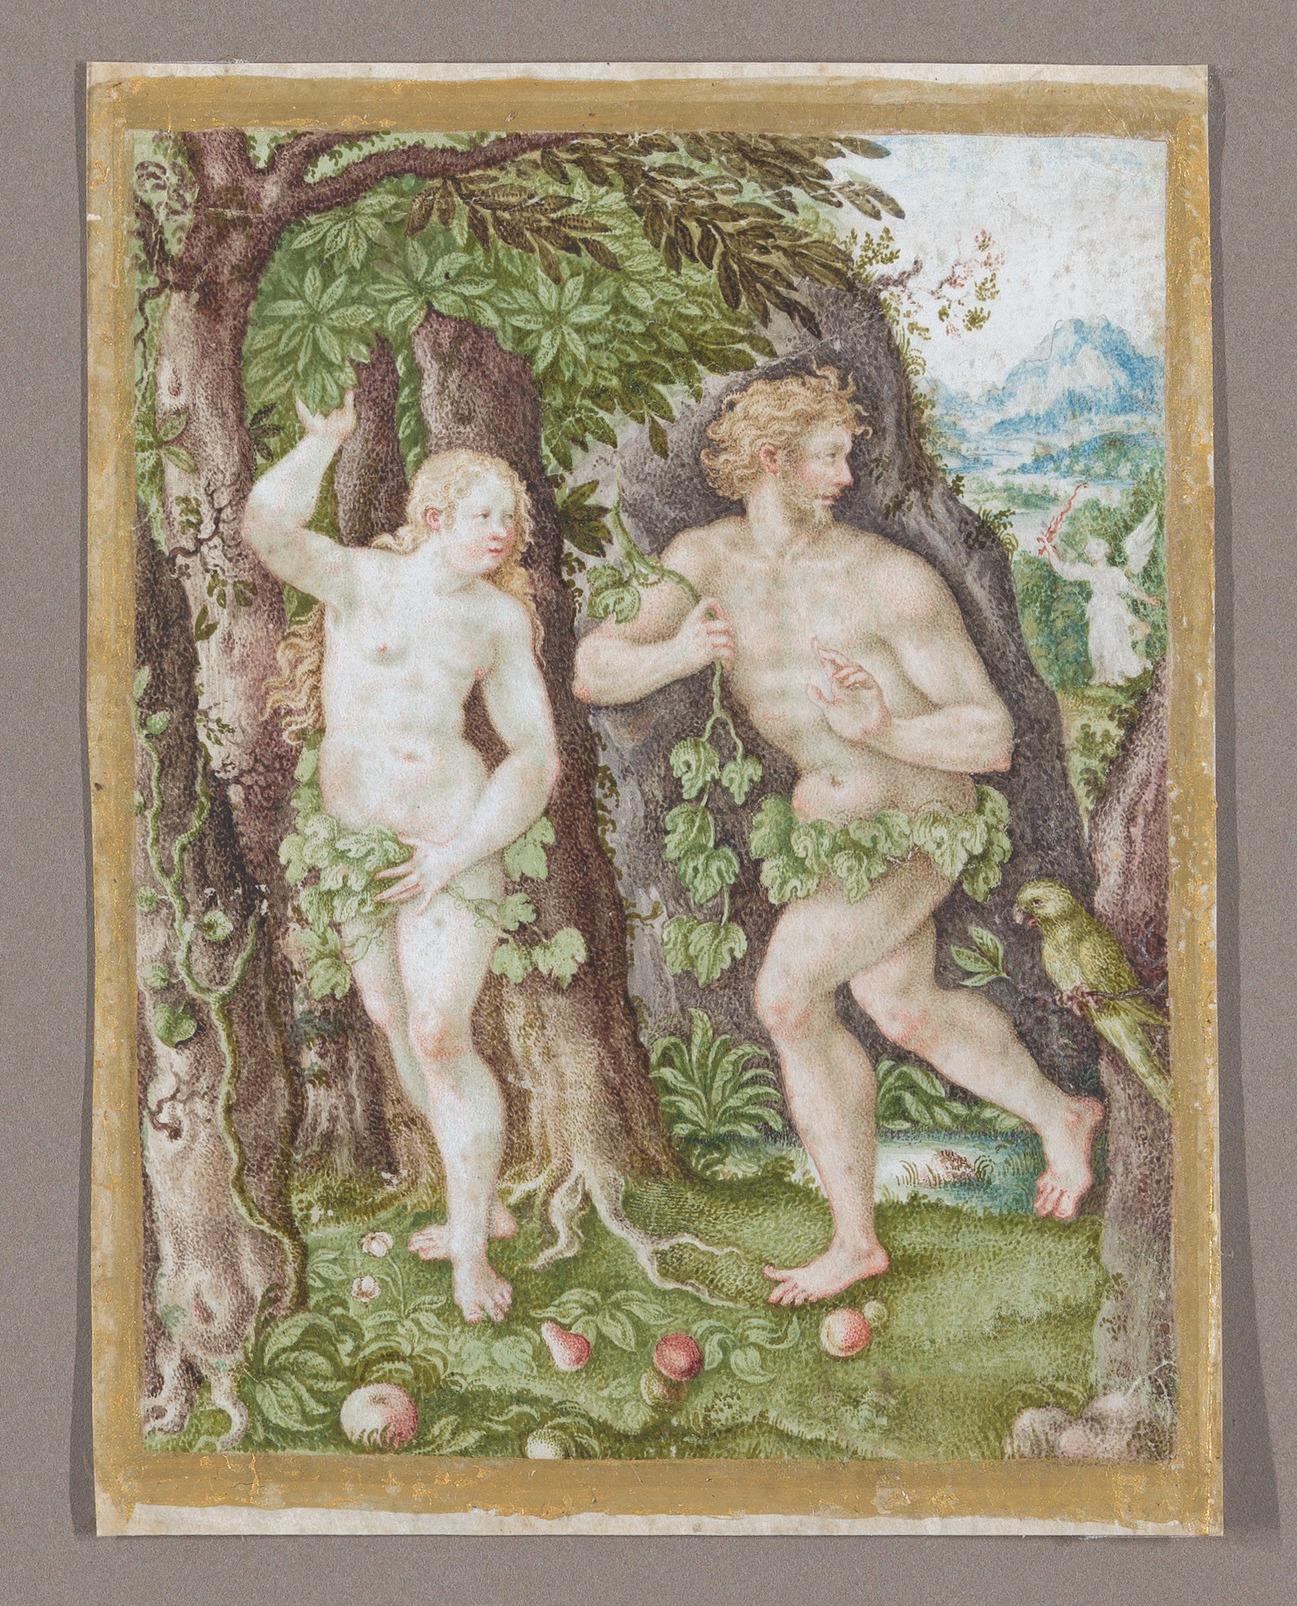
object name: drawing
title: The Expulsion from Paradise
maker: daniel fröschl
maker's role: artist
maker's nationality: german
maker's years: 1563-1613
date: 1567-1633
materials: gold, gouache, parchment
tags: fruit,men,female nudes,parrots,trees